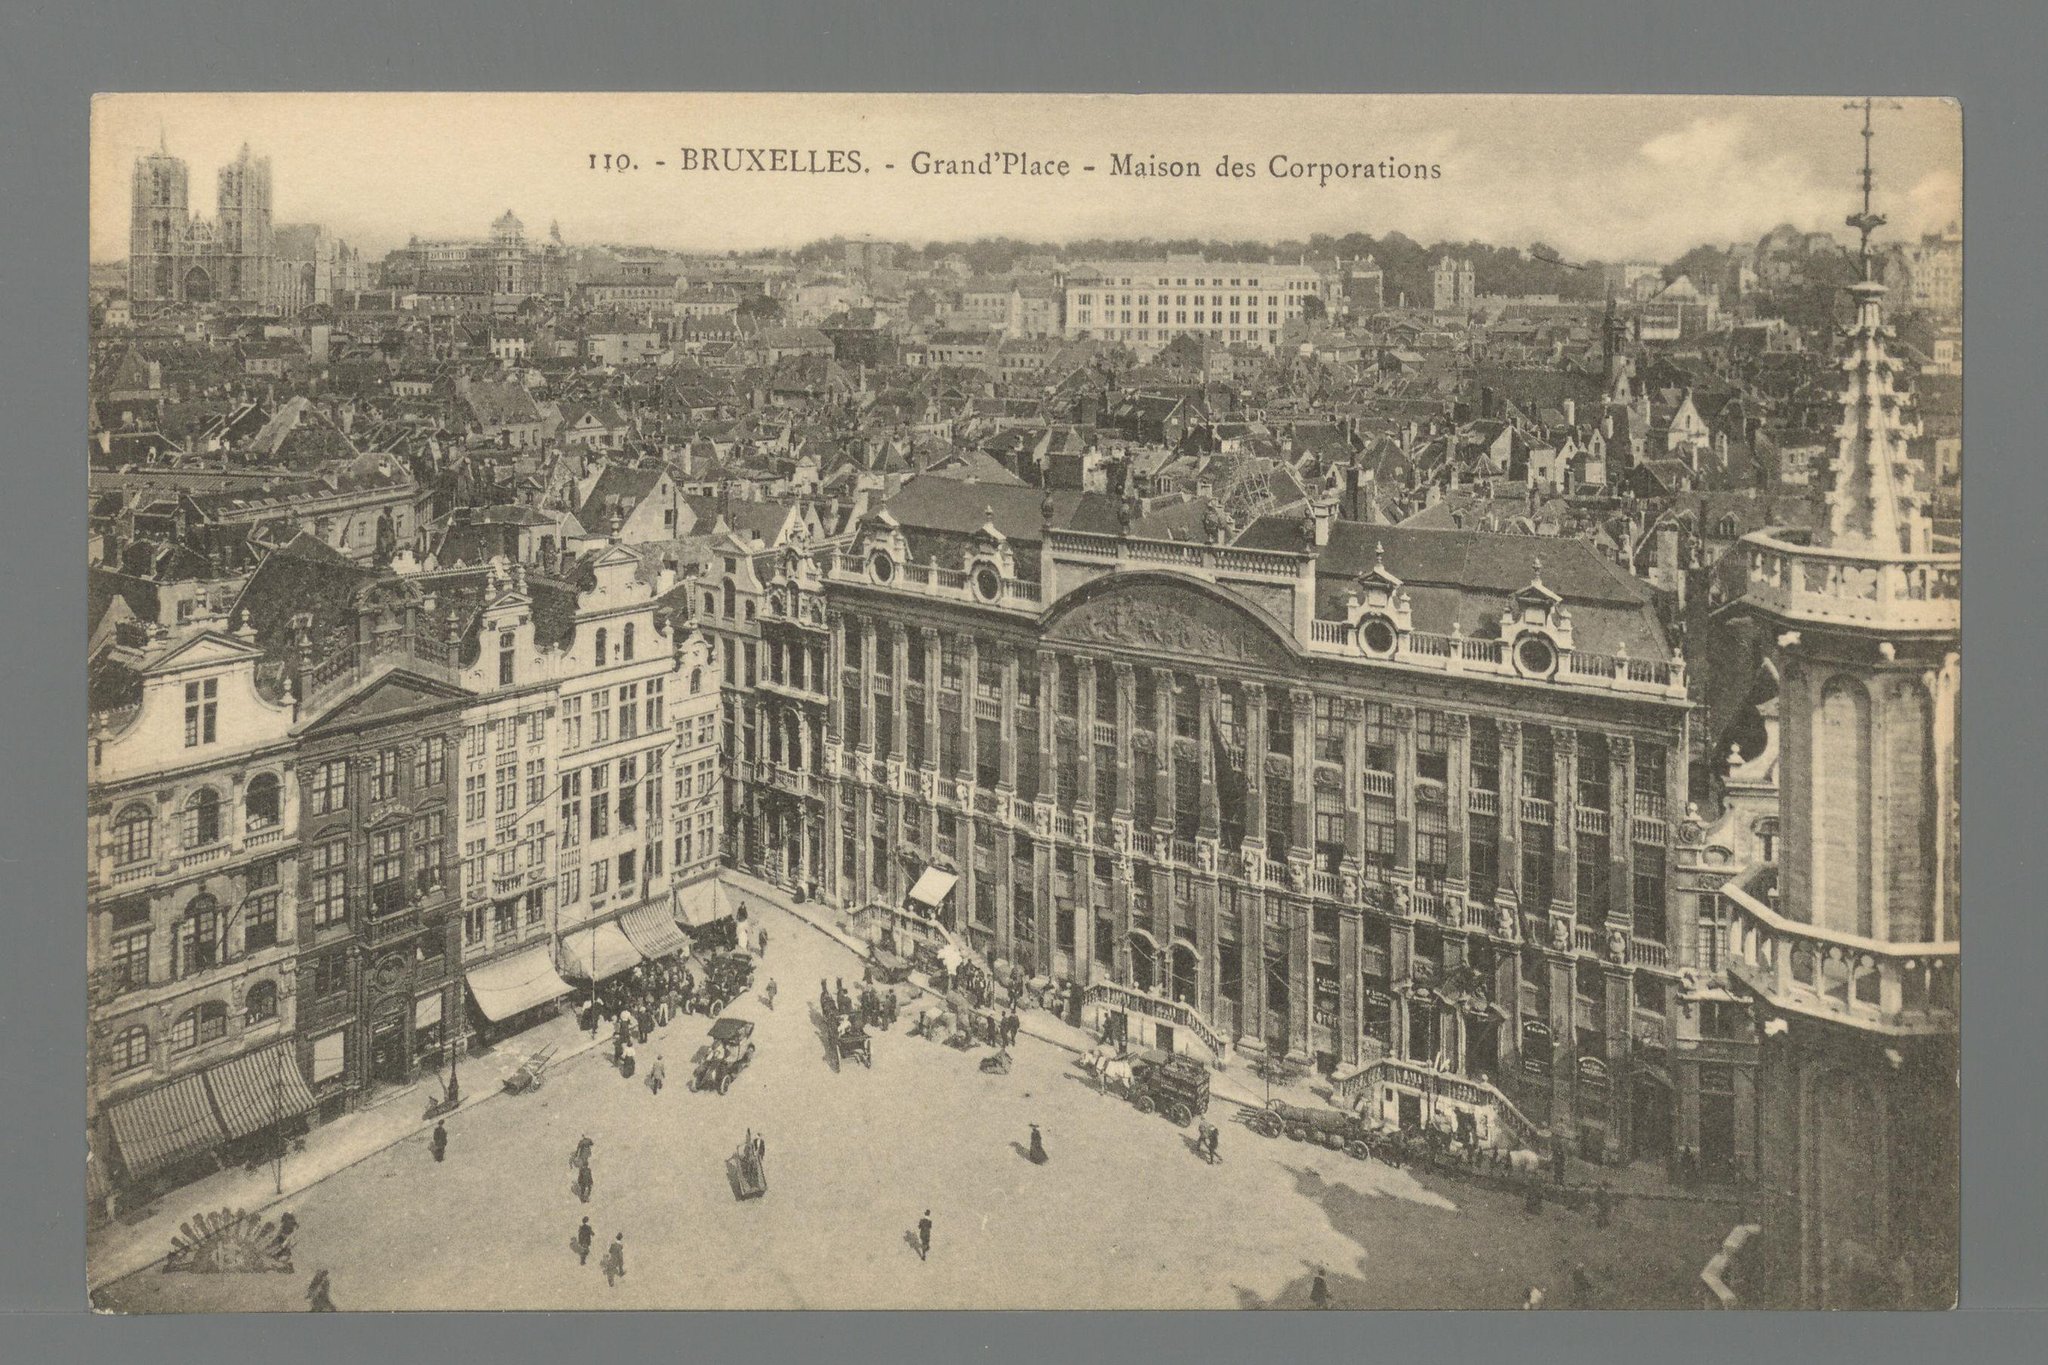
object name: photomechanical print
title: Bruxelles. Grand'Place. Maison des Corporations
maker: Anonymous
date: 1906-1930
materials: cardboard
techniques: photograph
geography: brussels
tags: square, place, circus, etc., prospect of city, town panorama, silhouette of city (+ city(-scape) with figures, staffage)